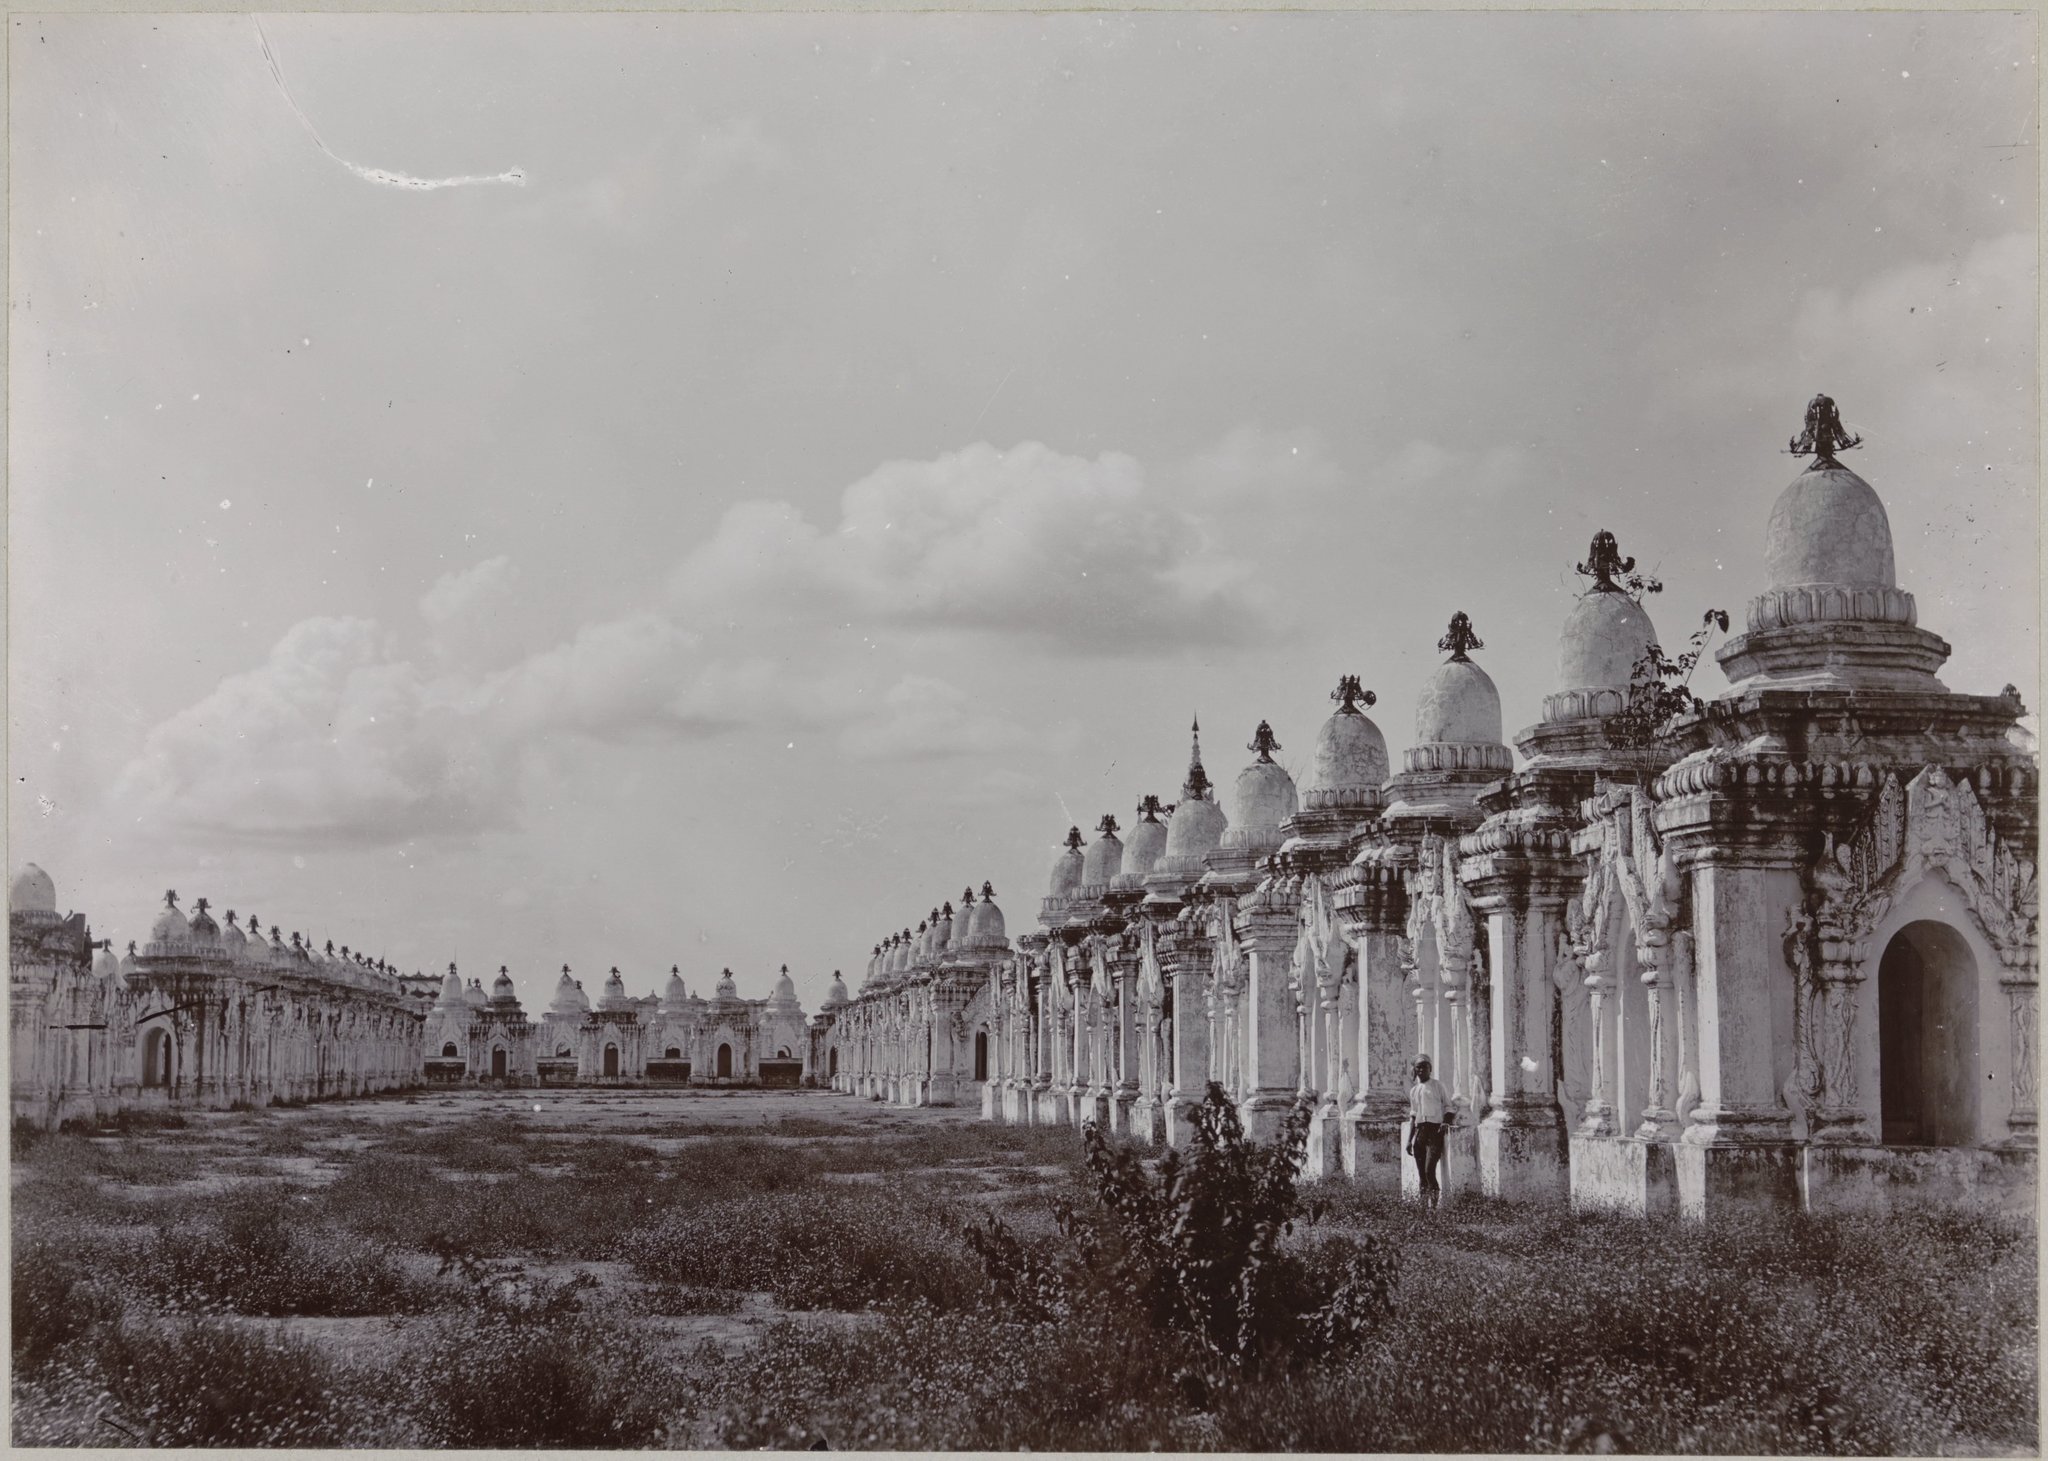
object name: photograph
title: 450 pagodas, Mandalay, Myanmar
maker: Anonymous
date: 1895-1915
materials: cardboard, paper, photographic support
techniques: collodion silver print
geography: mandalay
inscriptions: inscription: ‘17. De 450 pagoda's.’